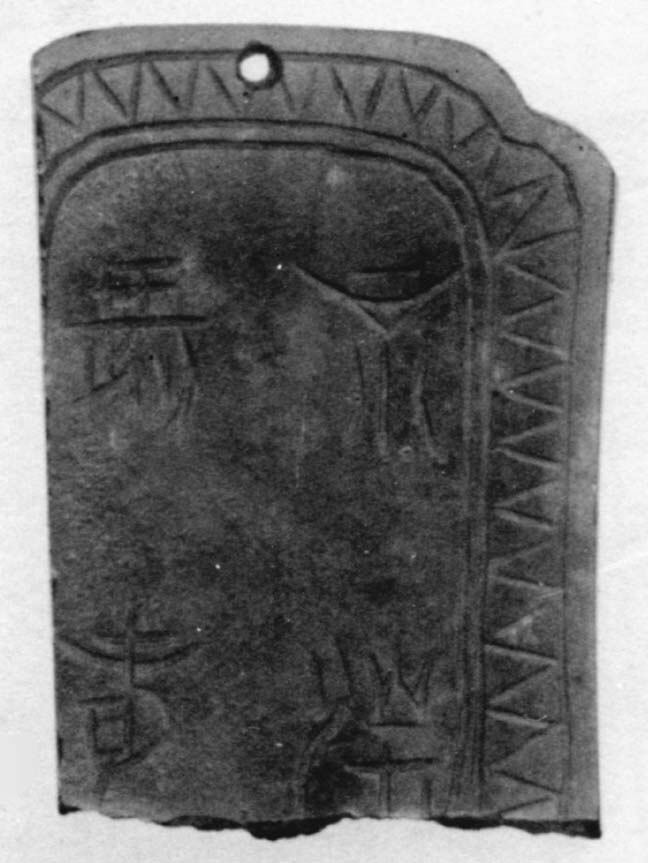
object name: fragment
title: Fragment of a Pendant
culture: chinese or turkestani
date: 1902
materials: jade